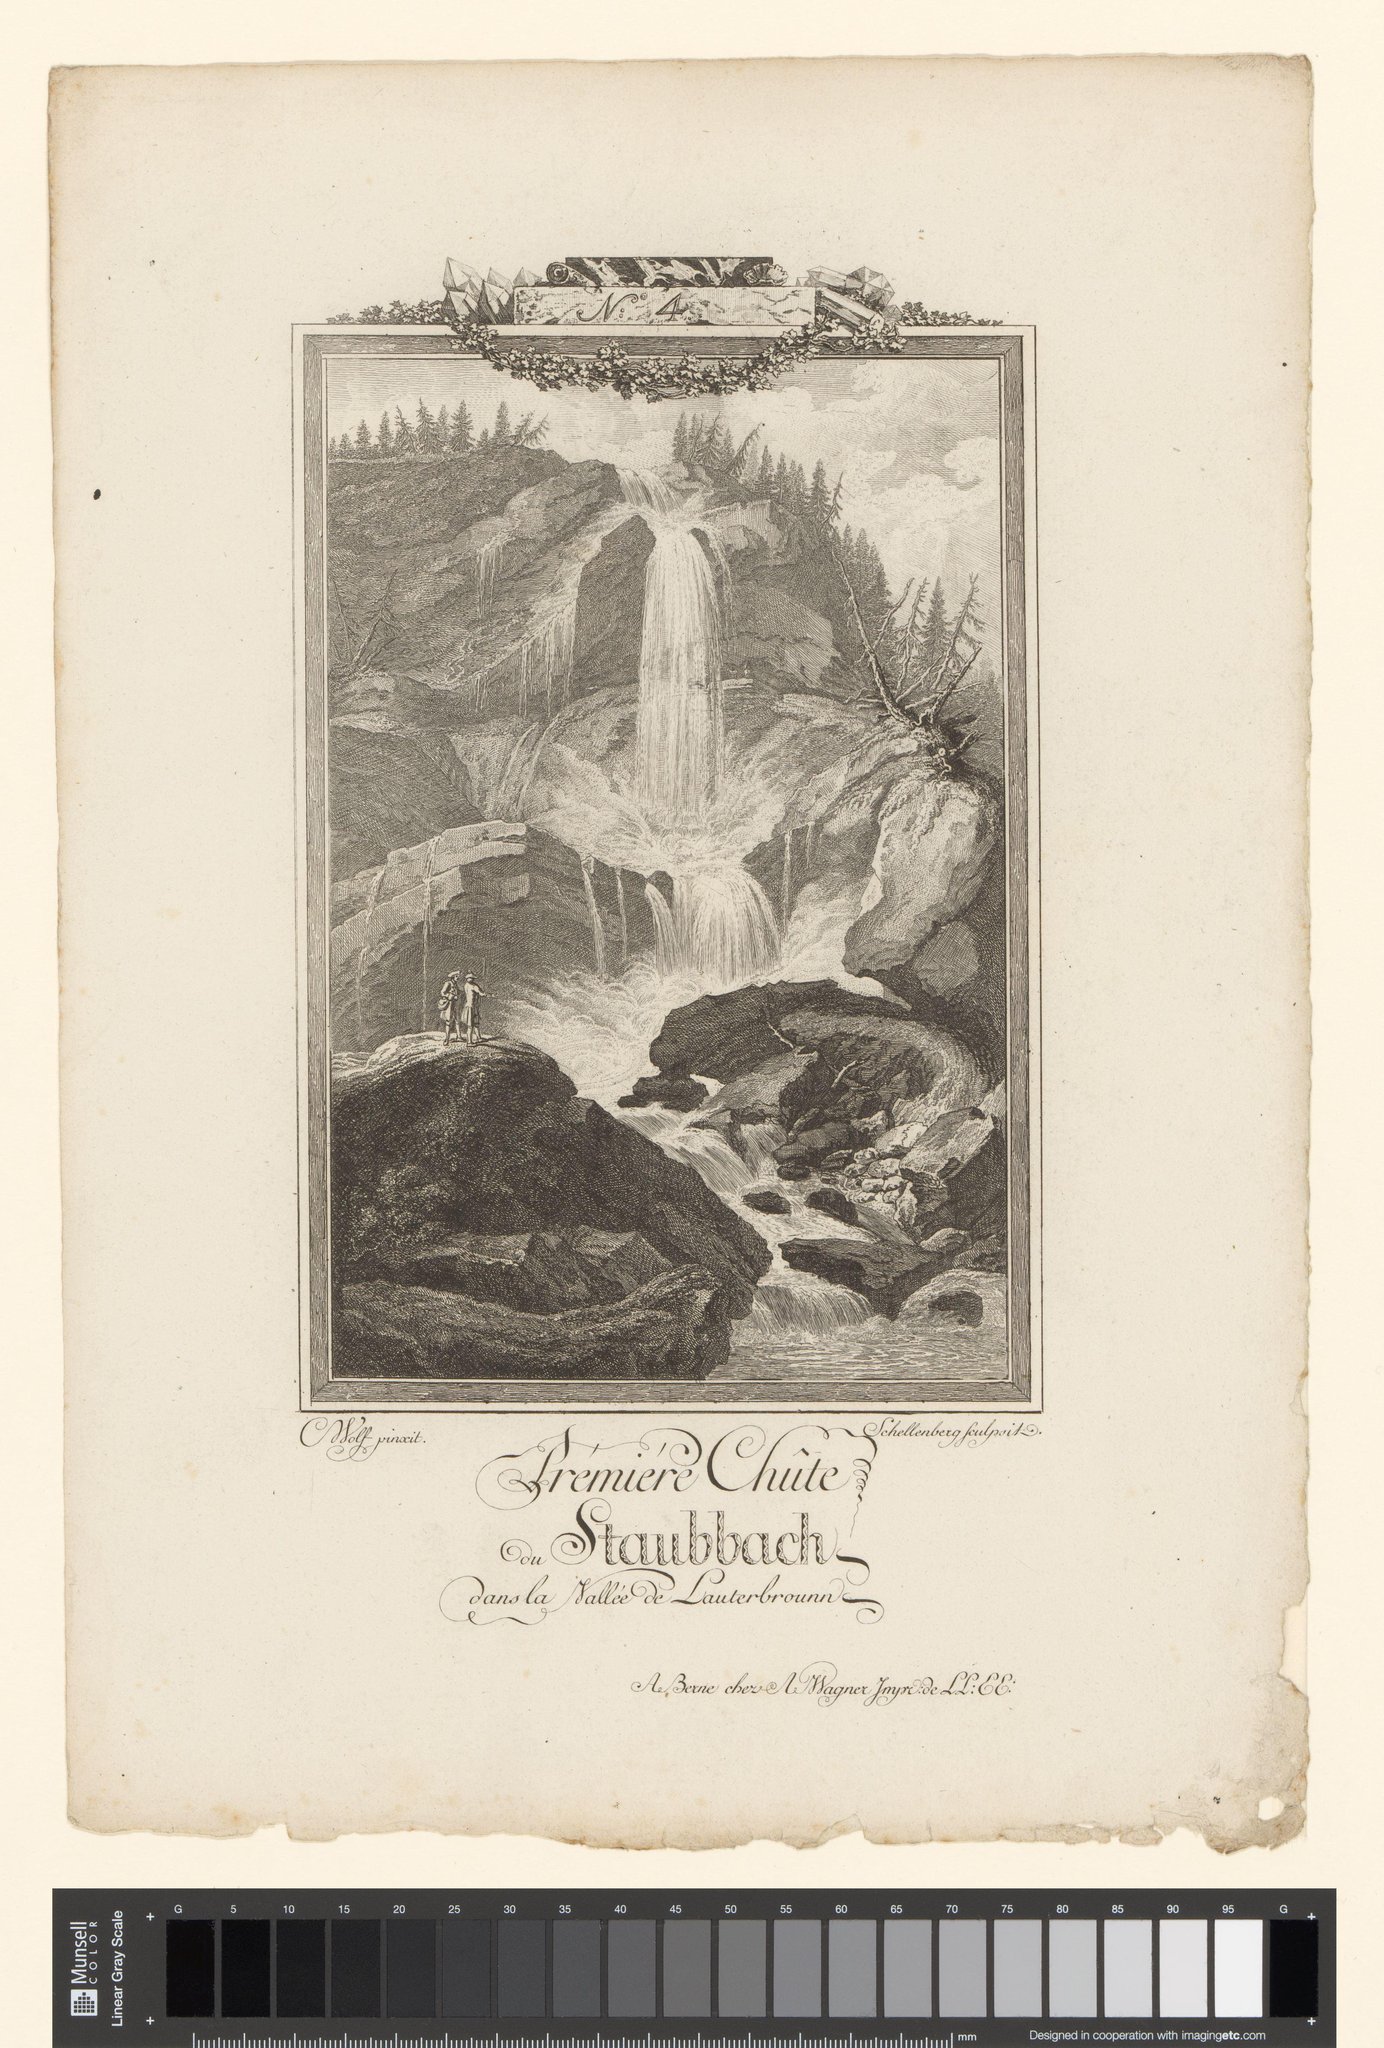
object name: print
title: Première Chûte du Staubbach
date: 1776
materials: paper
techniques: etching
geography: bern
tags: glacier, mountains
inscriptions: collector's mark: Lugt 2228